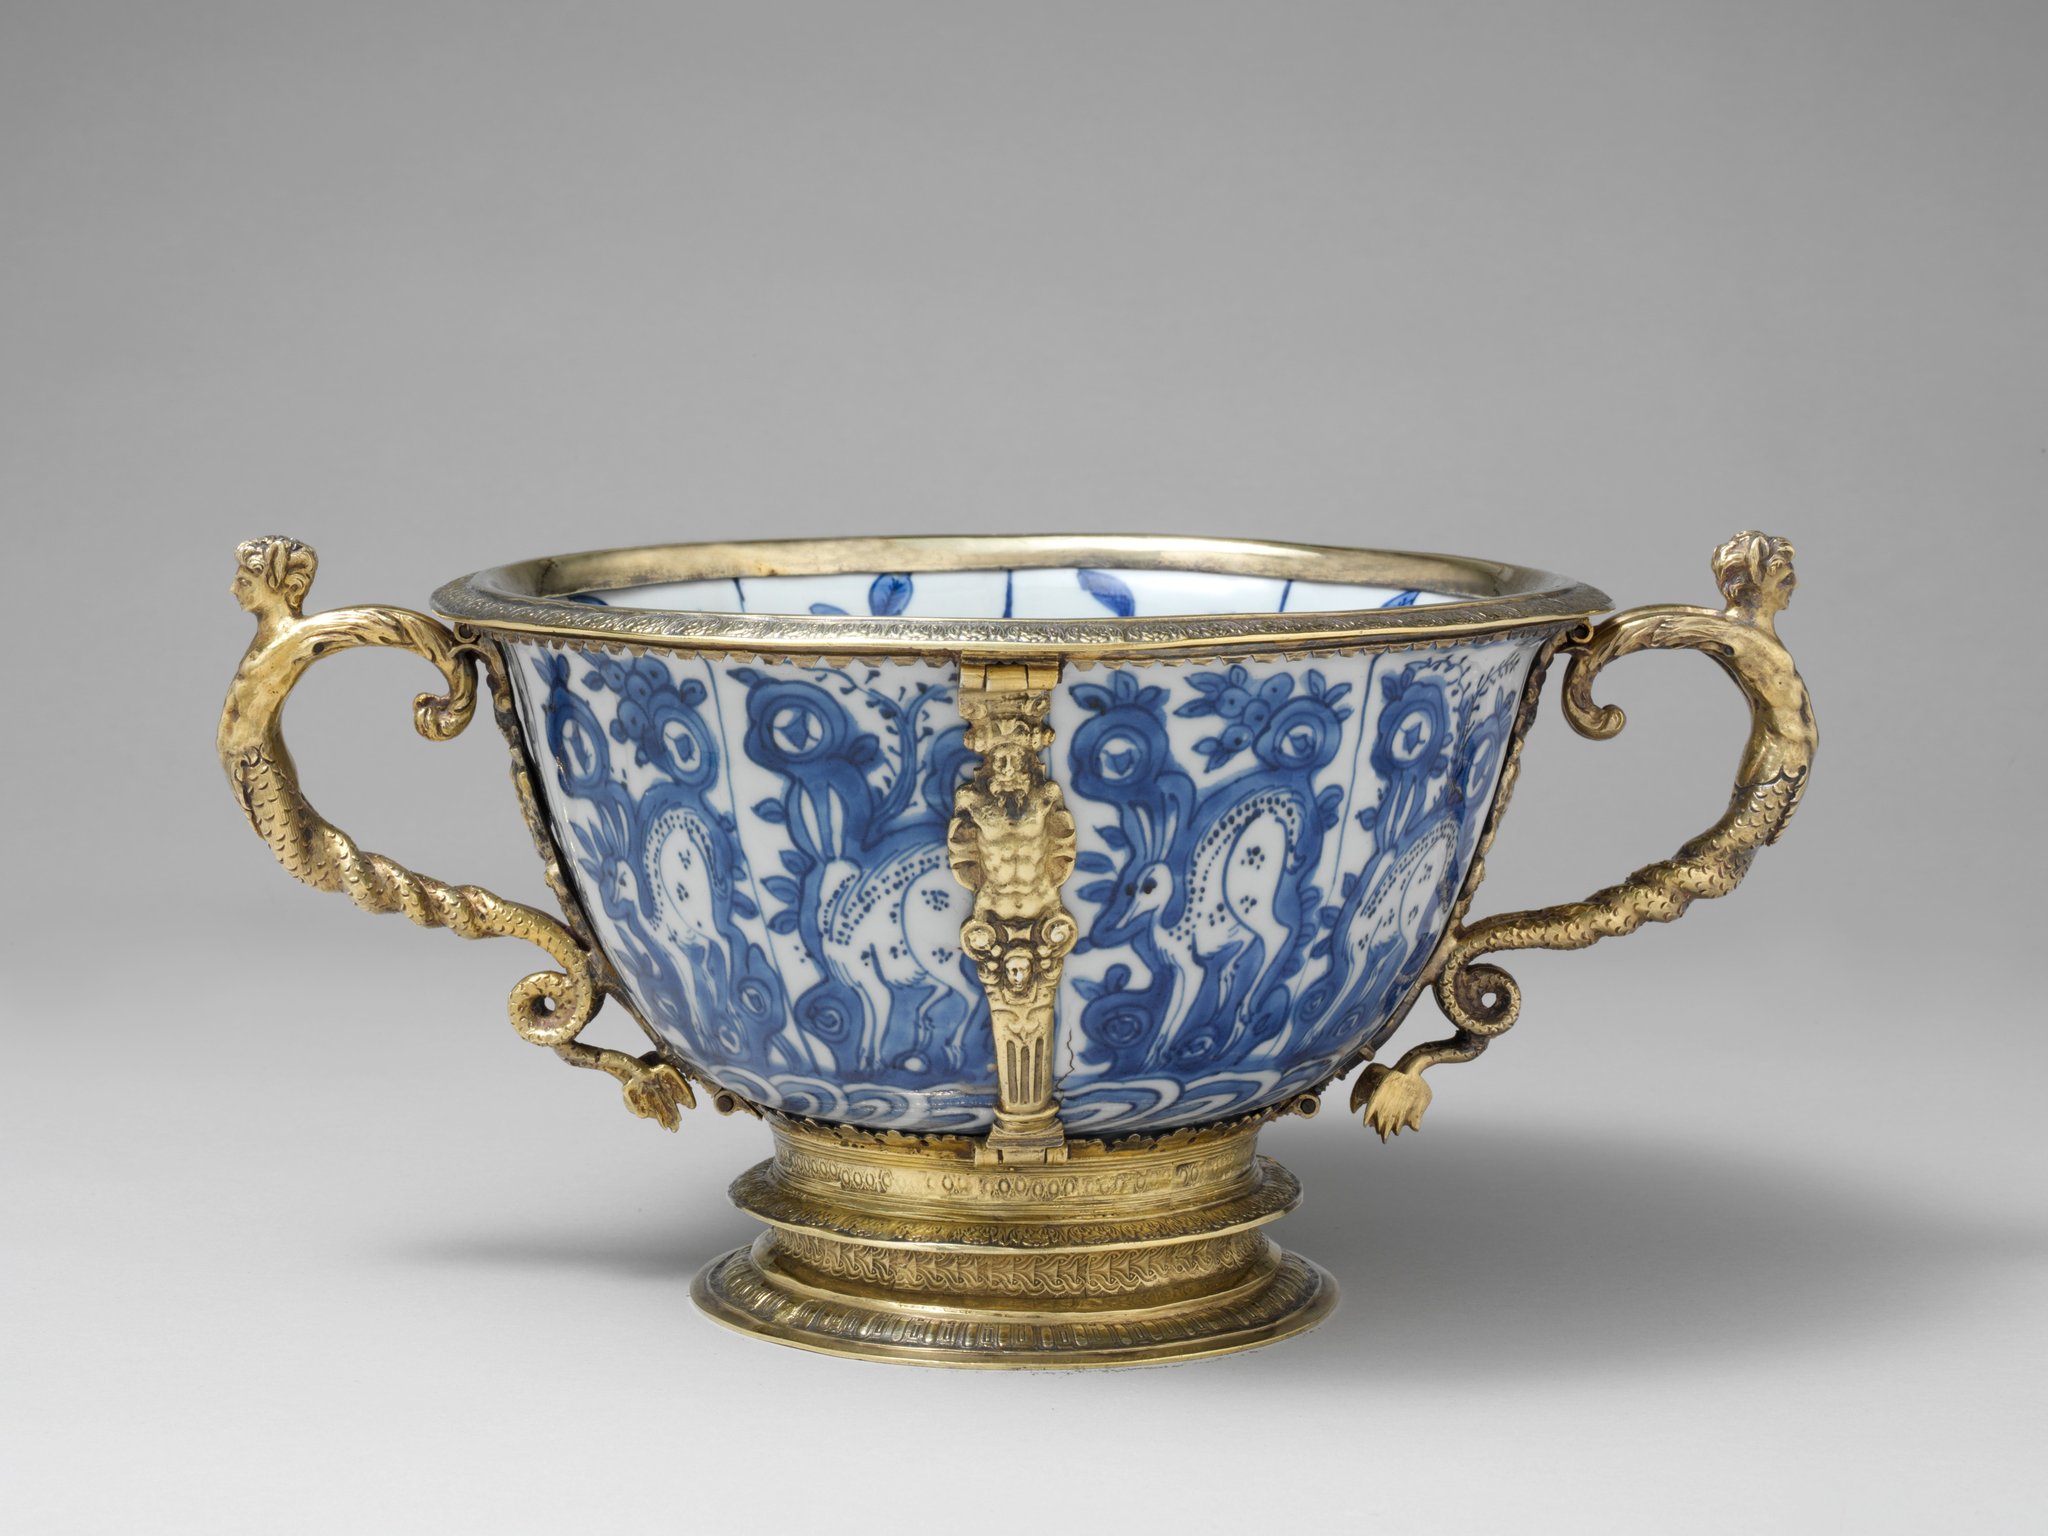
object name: bowl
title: Two-handled bowl from Burghley House, Lincolnshire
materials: gilt silver, hard paste porcelain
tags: deer